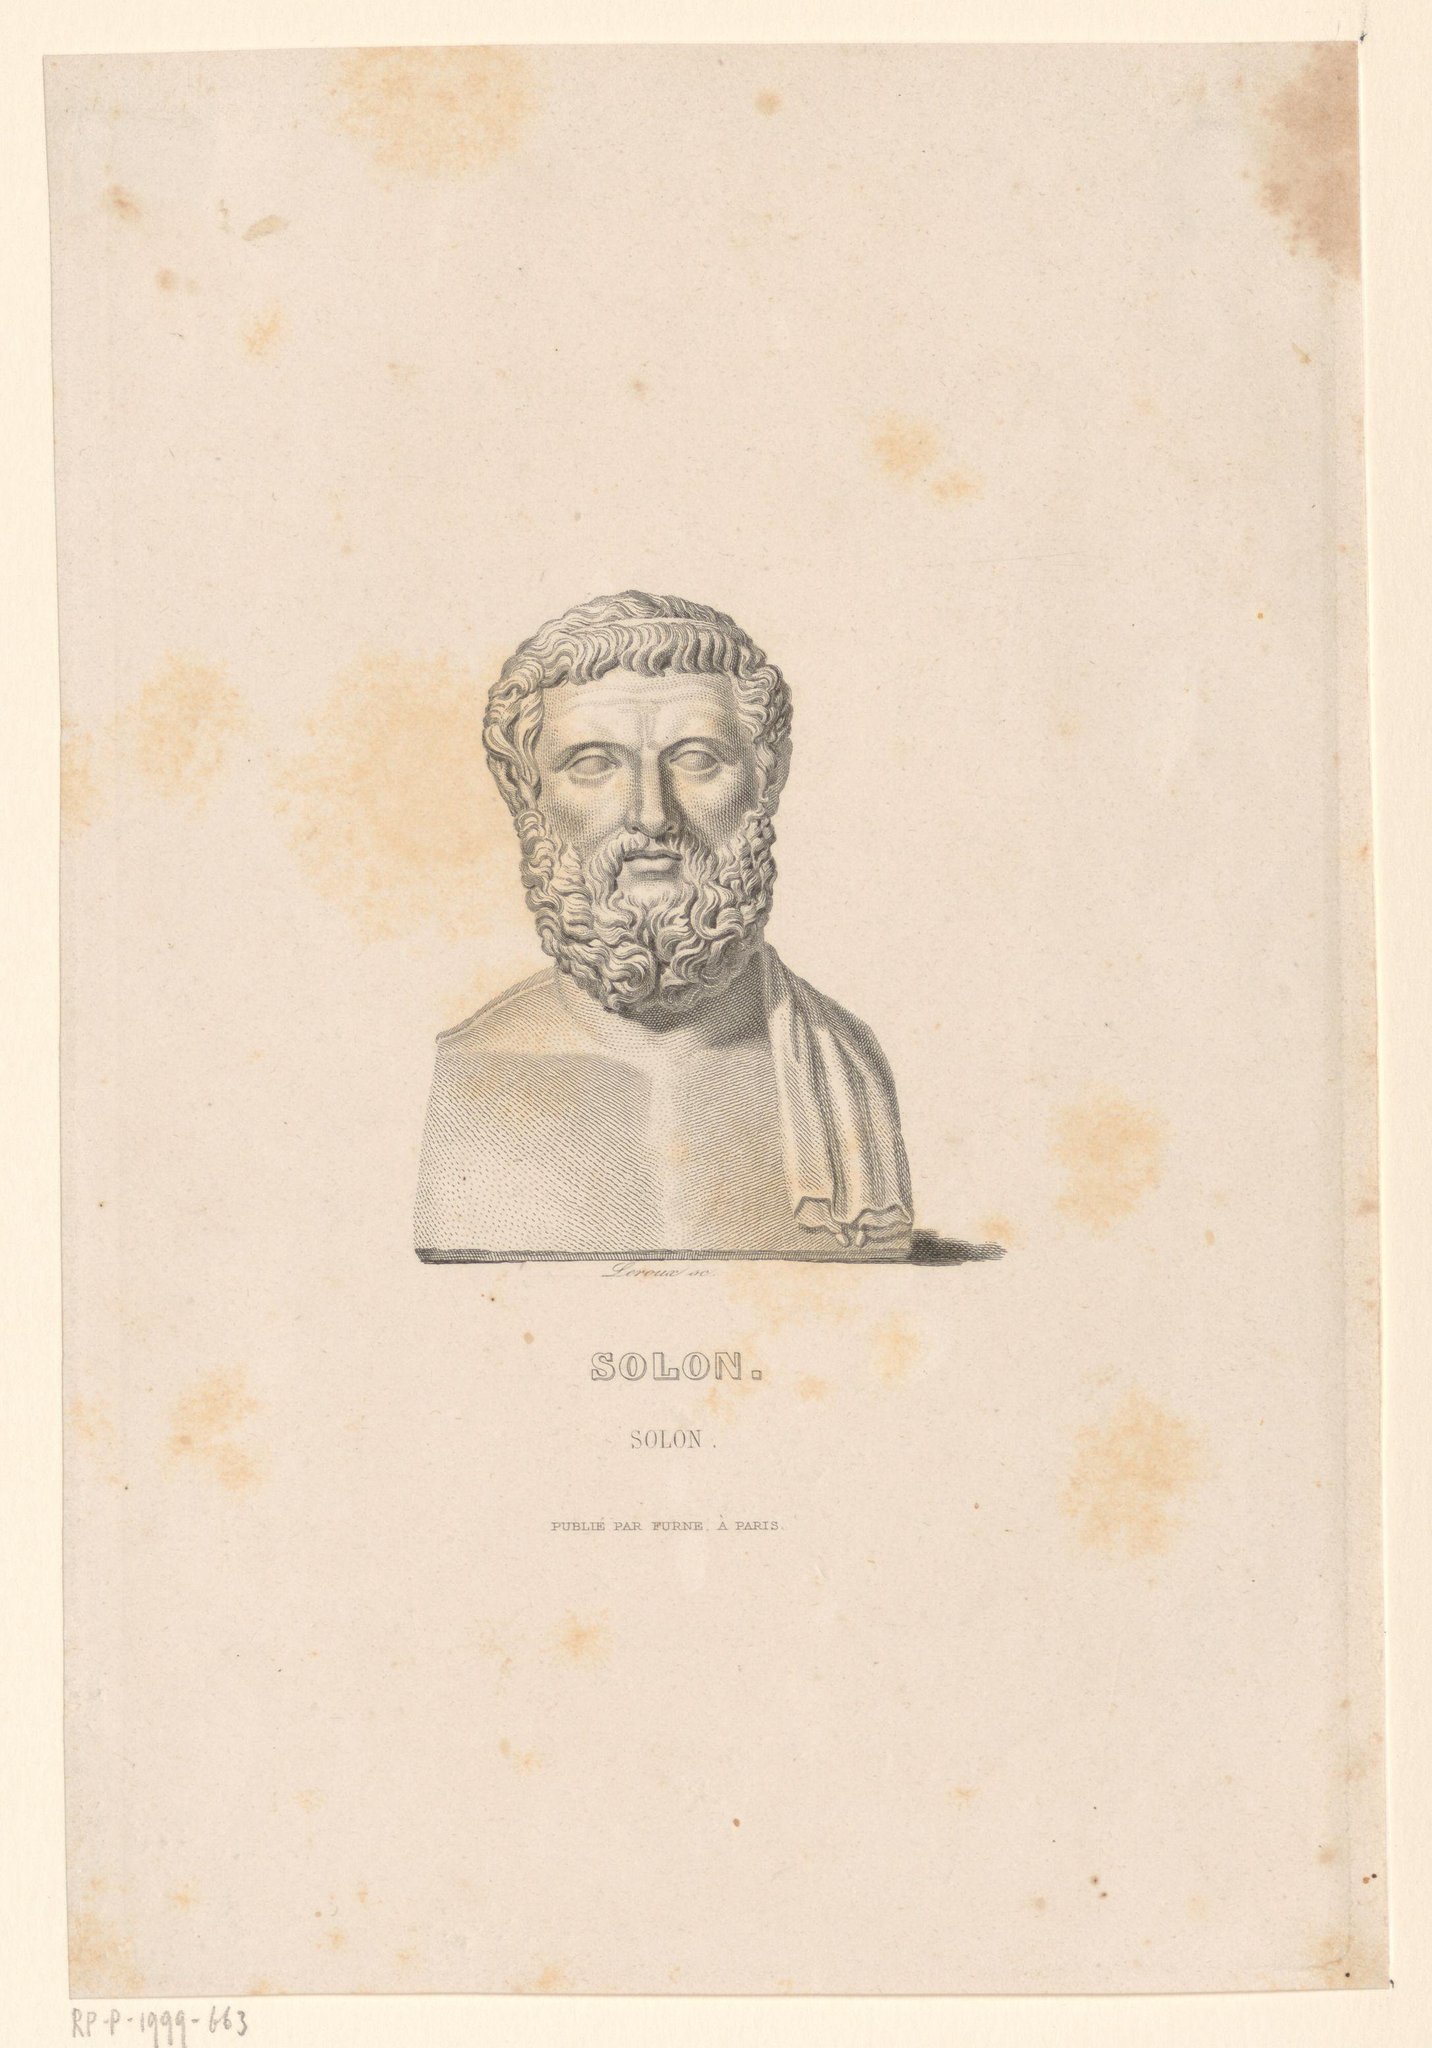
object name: print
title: Portretbuste van Solon van Athene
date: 1750-1849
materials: paper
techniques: etching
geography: paris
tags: solon, historical persons, piece of sculpture, reproduction of a piece of sculpture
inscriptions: collector's mark: Lugt 2228, collector's mark: Lugt 2760